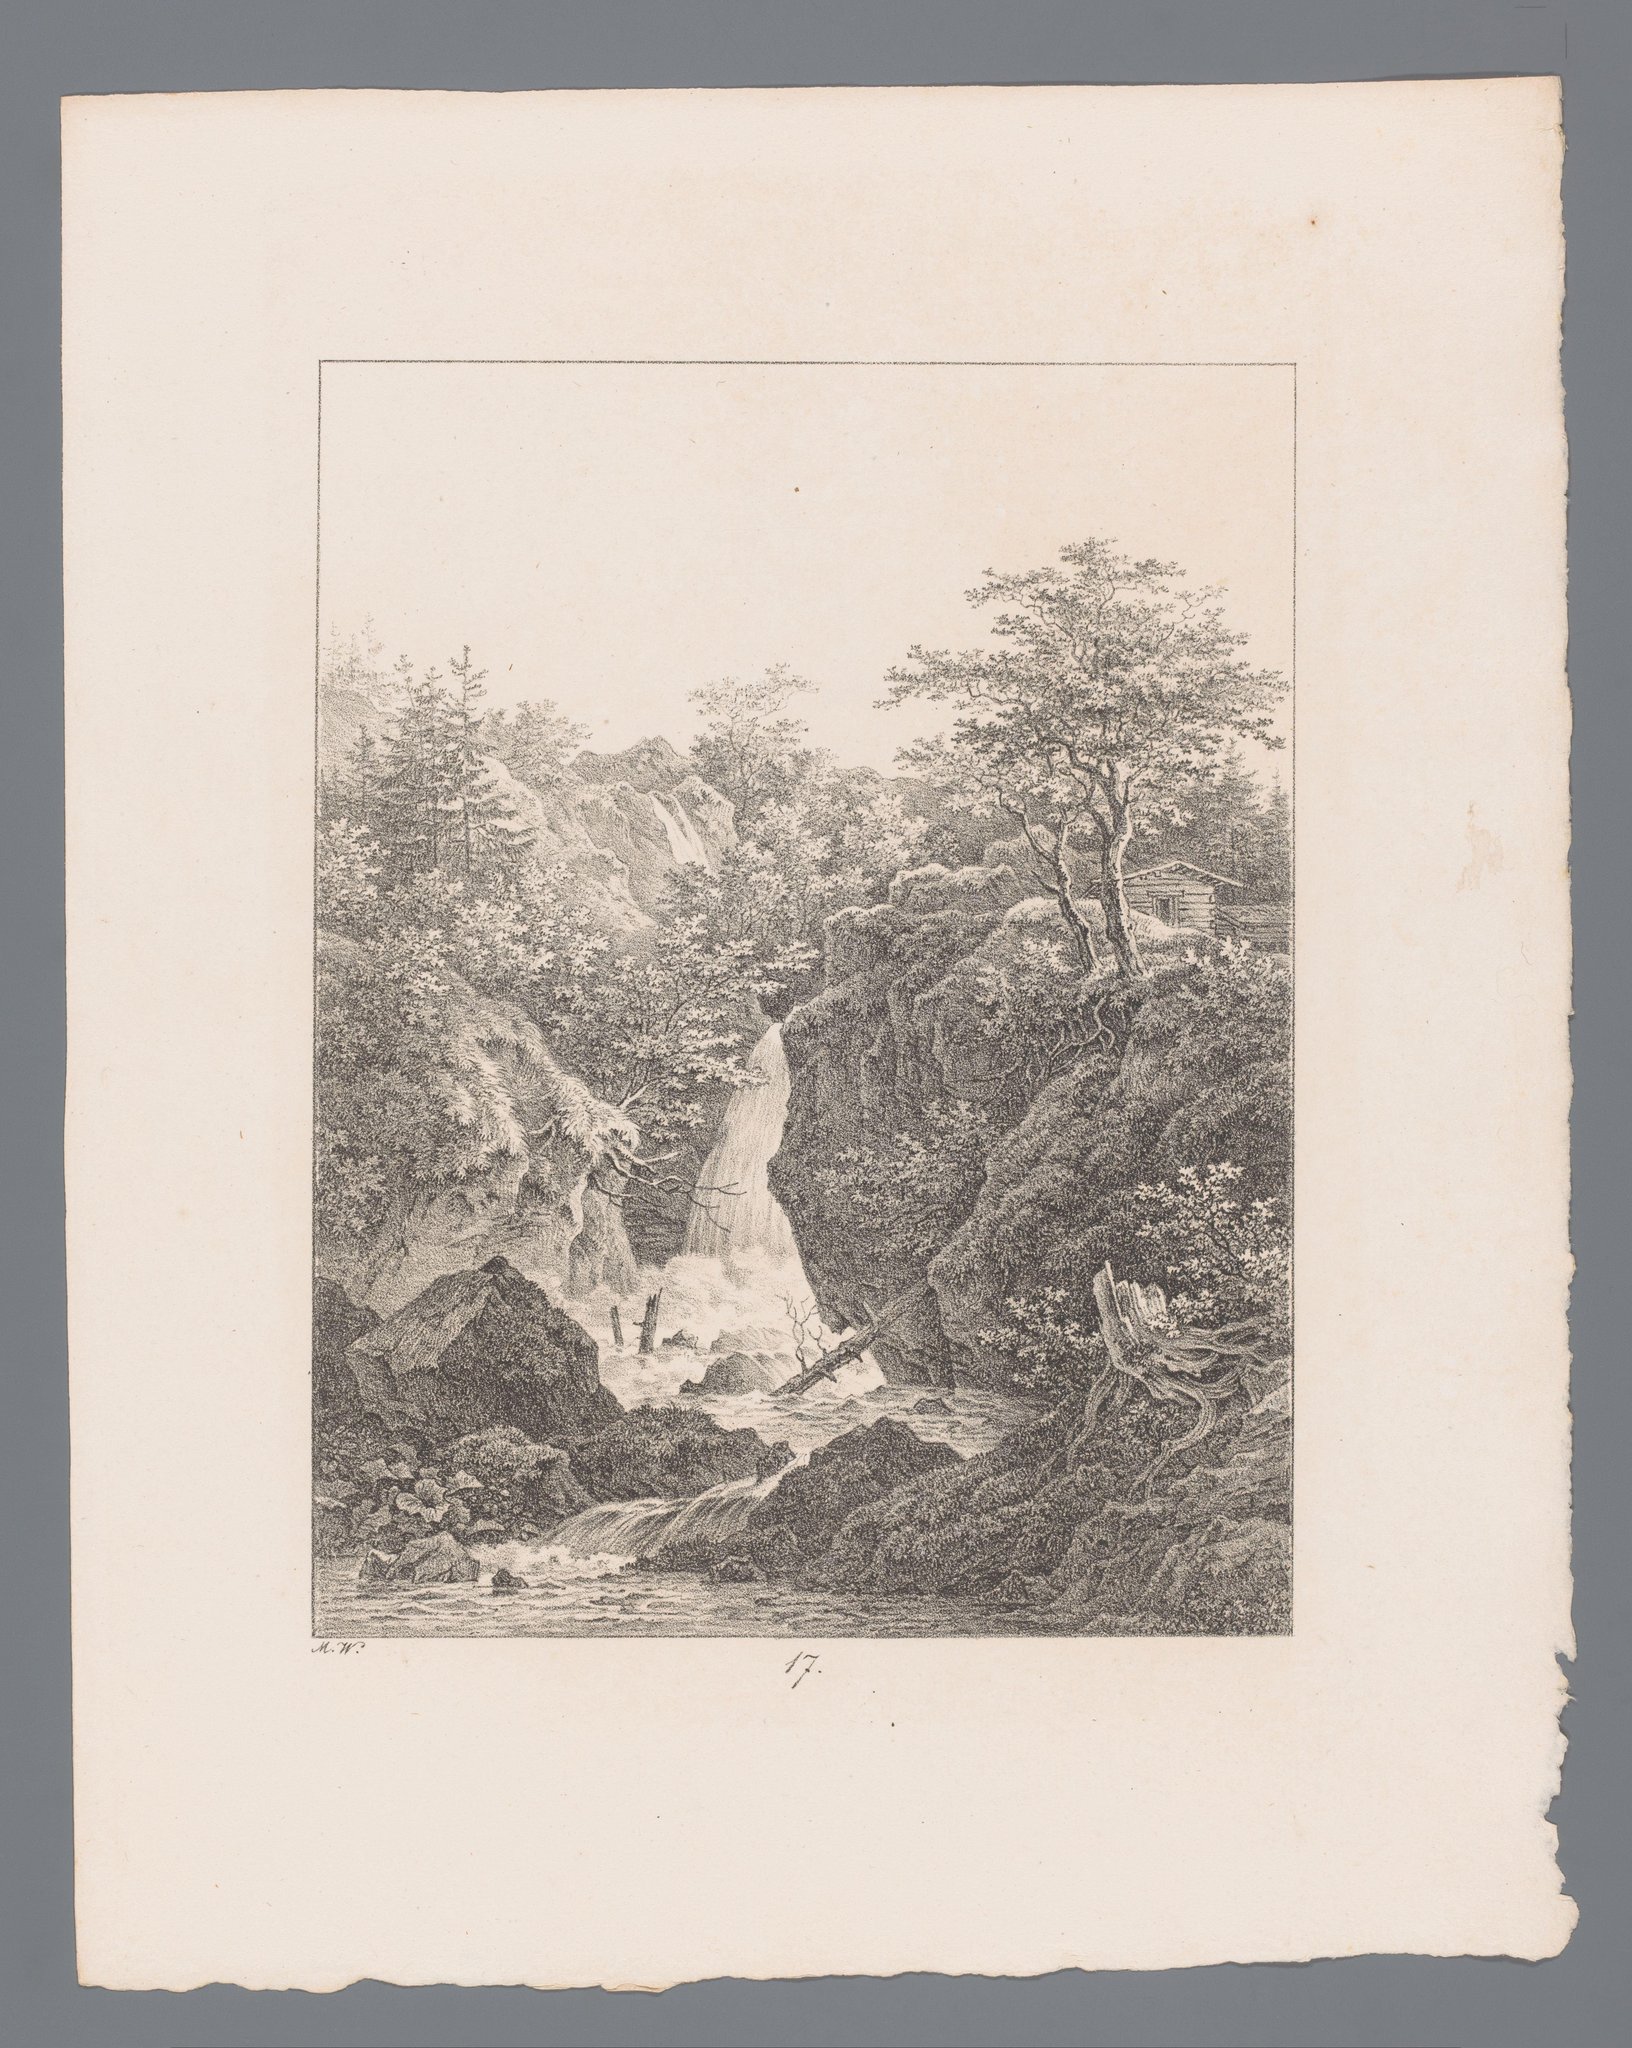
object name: print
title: Vorlagen für Landschaft-Zeichner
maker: max josef wagenbauer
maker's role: print maker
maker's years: 1774-1829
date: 1823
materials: paper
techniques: lithograph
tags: trees, waterfall, rocks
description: Onderdeel van een tweedelige serie waarvan het eerste deel bestaat uit een titelprent en twintig voorstellingen van takken, bladeren, bomen en landschappen.